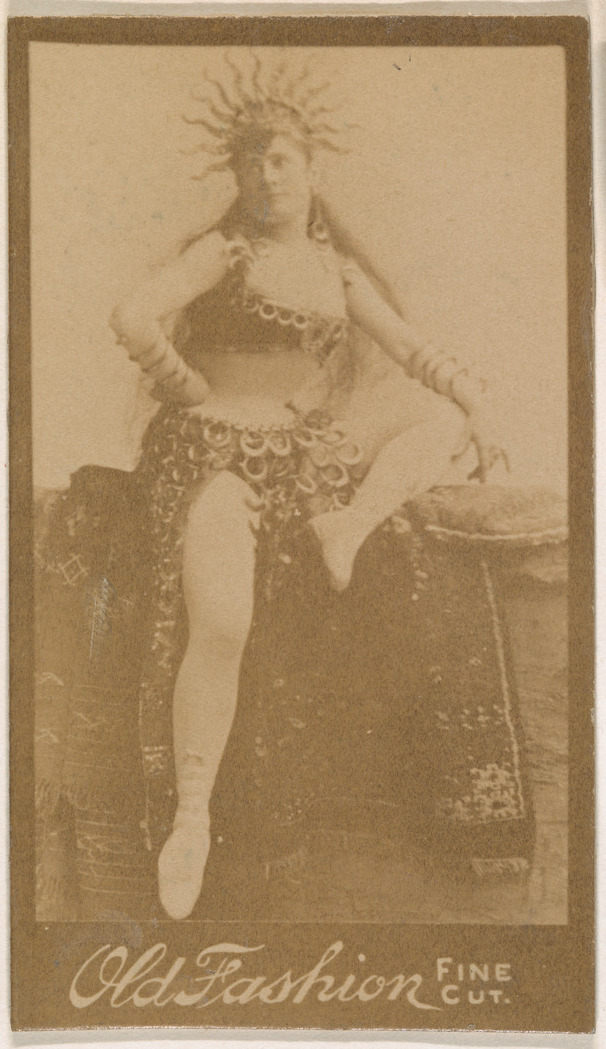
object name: photograph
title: Actress wearing spiked headpiece, from the Actresses series (N664) promoting Old Fashion Fine Cut Tobacco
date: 1888-1890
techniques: albumen silver print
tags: portraits,women,actresses